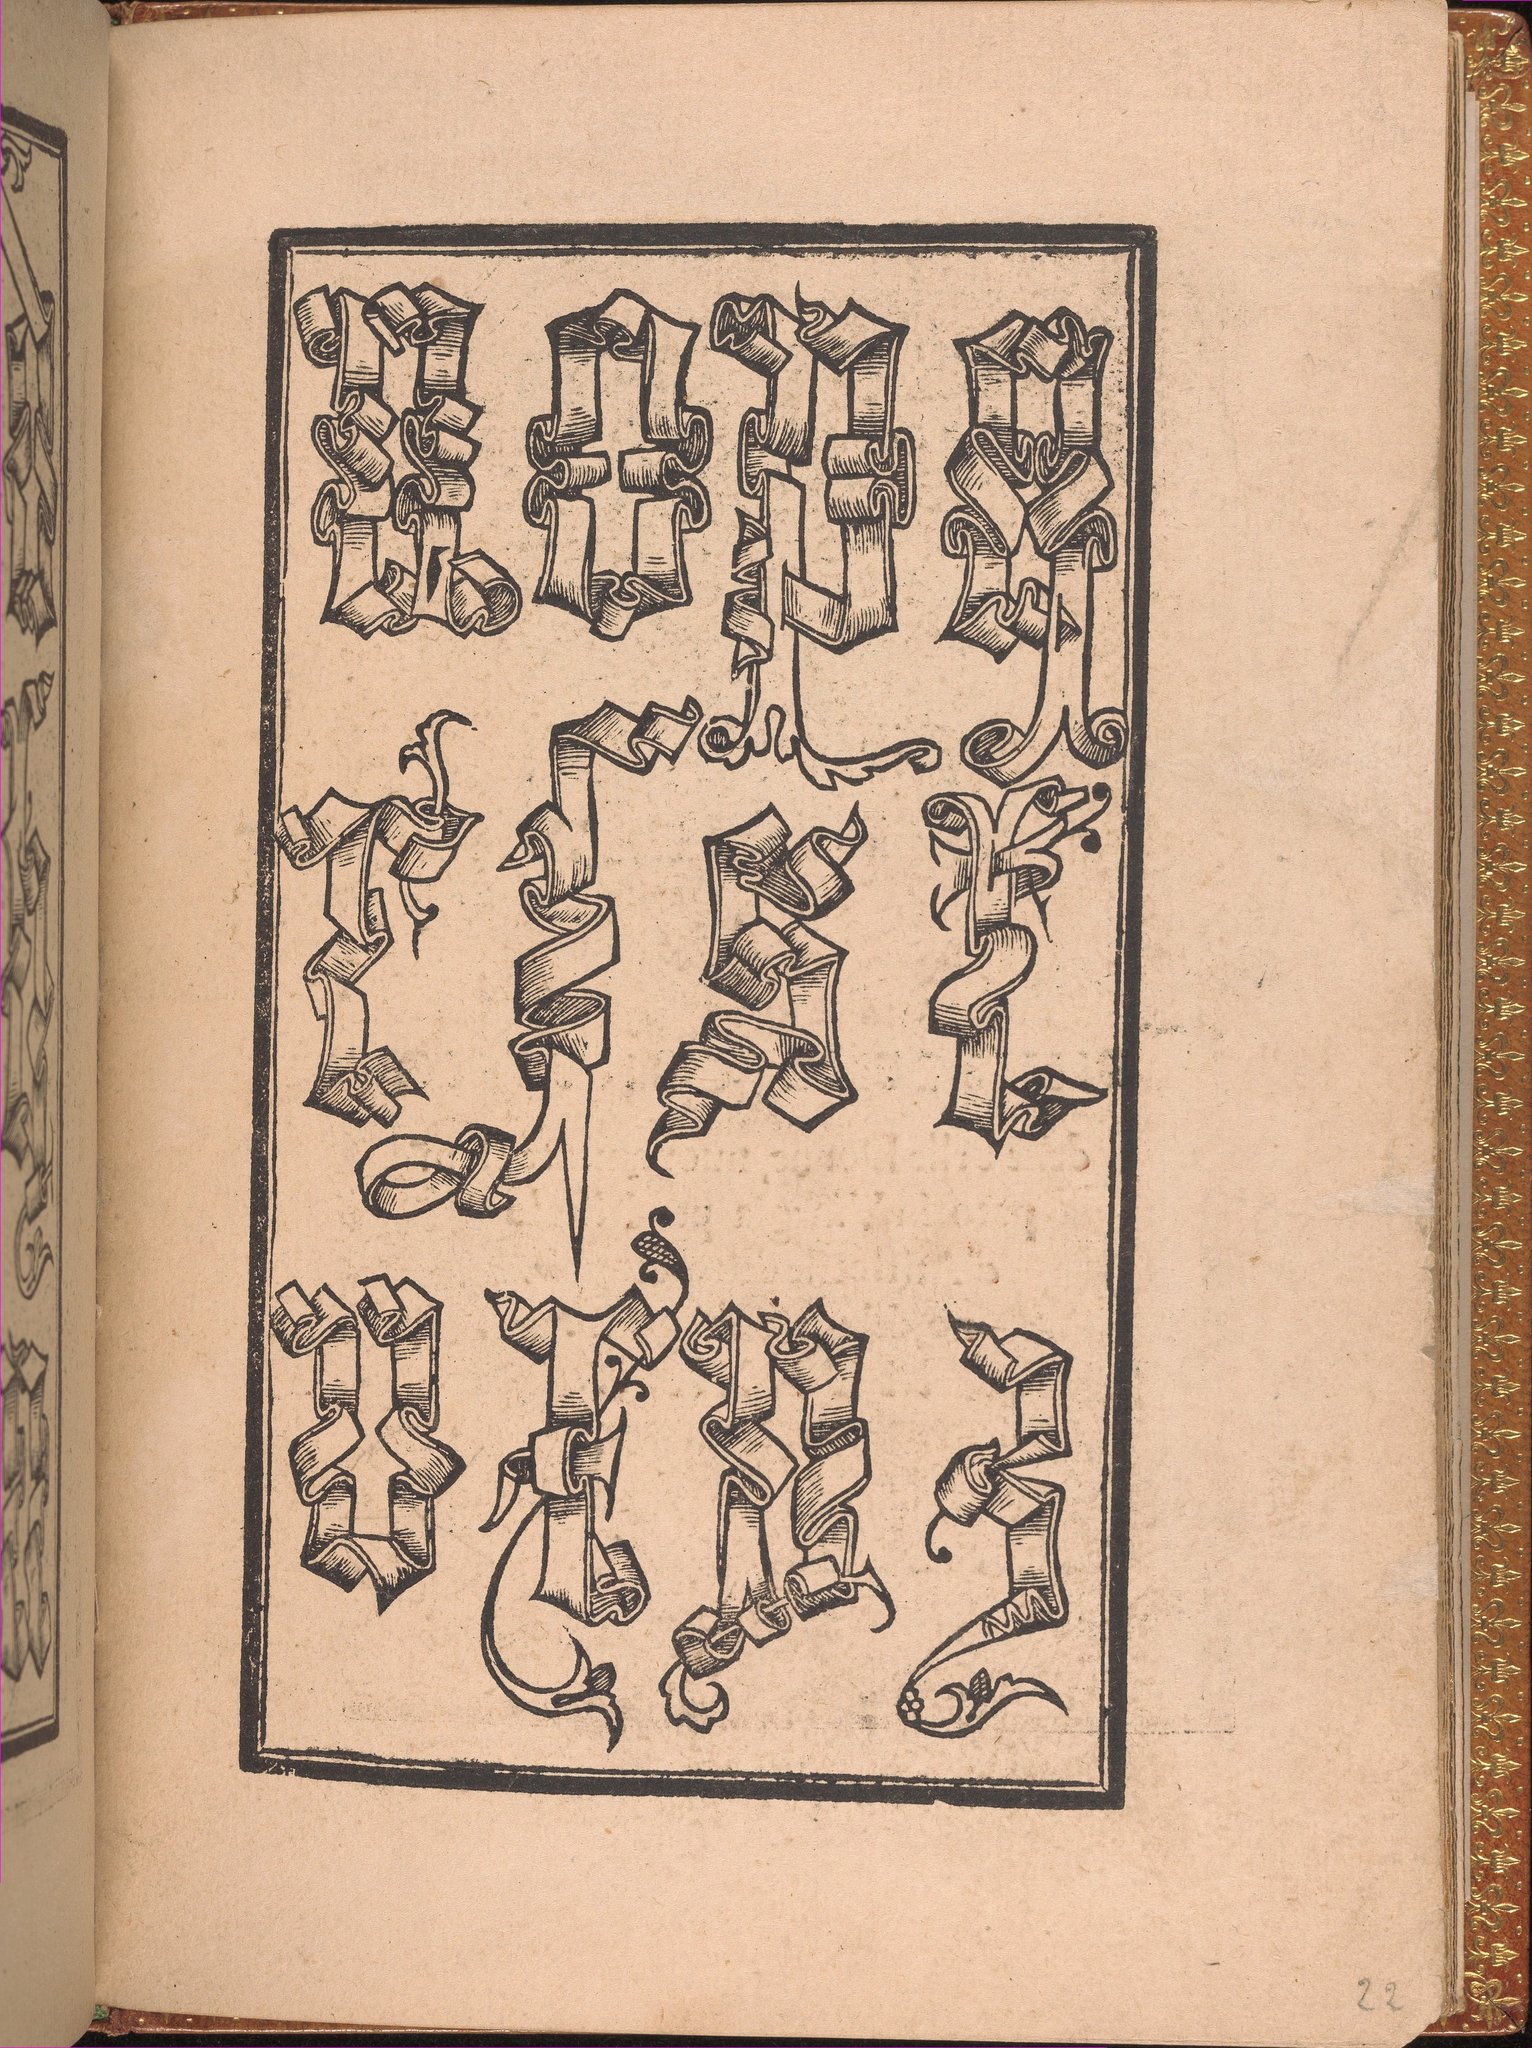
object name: book print ornament architecture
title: Convivio delle Belle Donne, page 22 (recto)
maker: nicolò zoppino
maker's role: publisher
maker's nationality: italian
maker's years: 1478-1544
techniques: woodcut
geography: italy